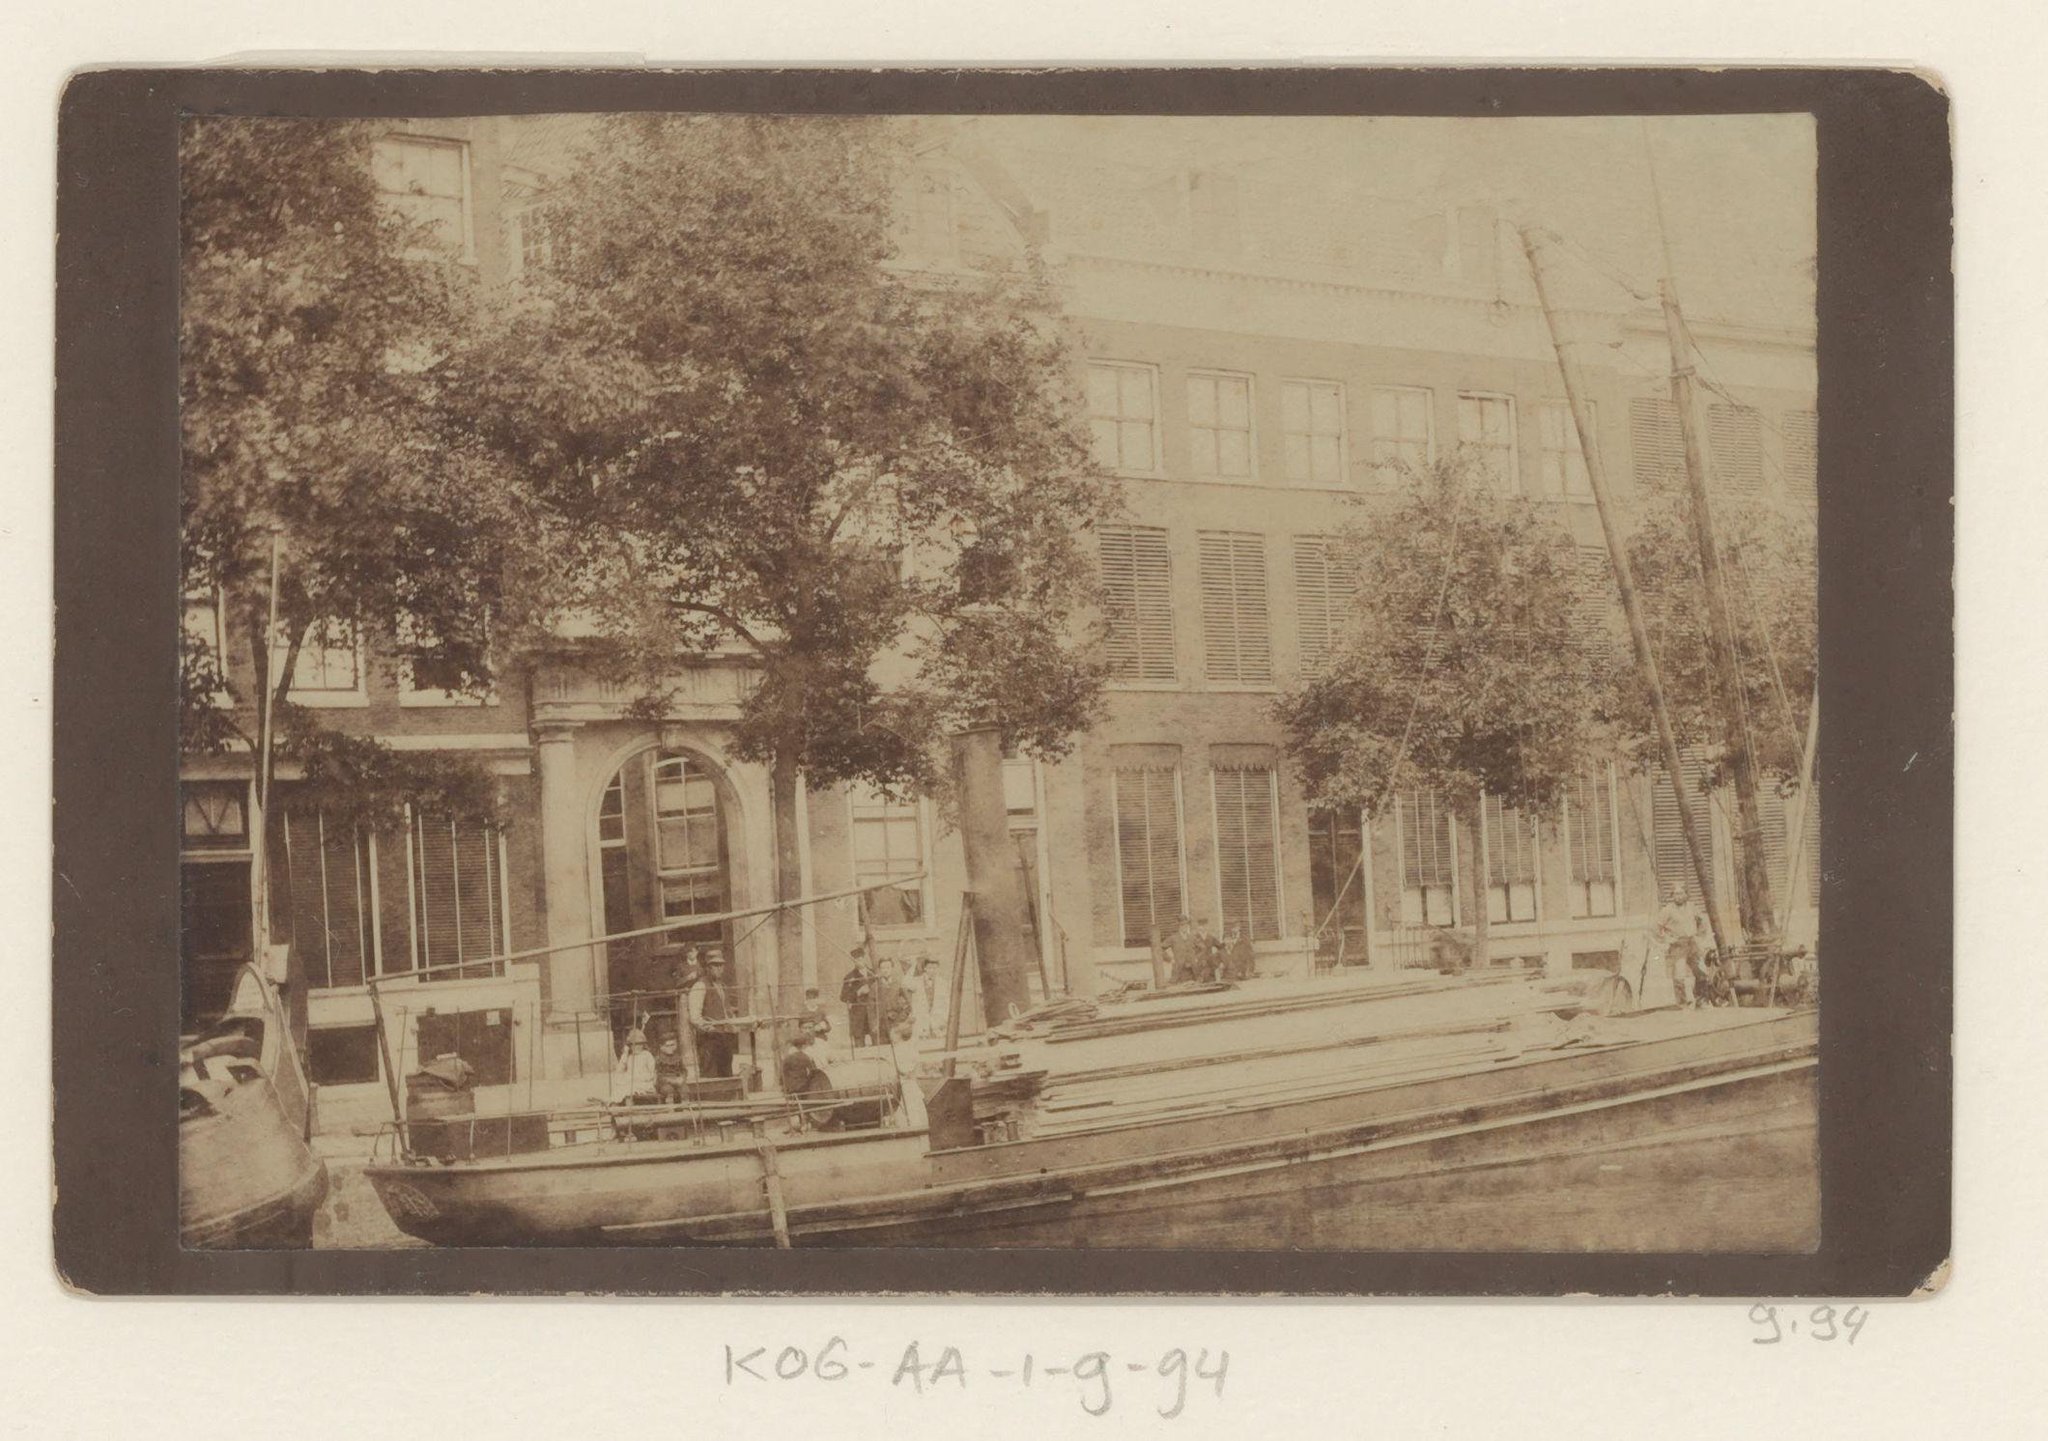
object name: cabinet photograph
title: Gezicht op de Kloveniersburgwal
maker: andreas theodorus rooswinkel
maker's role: fotograaf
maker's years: 1838-1909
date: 1868-1909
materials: cardboard, paper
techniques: albumen print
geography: amsterdam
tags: city-view in general; 'veduta', canal, the usual house or row of houses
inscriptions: collector's mark: ‘9.94’ Lugt 1641b, inscription: ‘Kloveniersburgwal’, stamp: ‘A.T. Rooswinkel / Photographe / Amsterdam.’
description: Onderwerpsrubriek binnen de Atlas Amsterdam: Kadijksplein, Karthuizerkerkhof, Kattegat, Kattenburg, Kapelsteeg O.Z., Enge Kerksteeg, Kerkstraat, Kinkerstraat, Kolk O.Z., Koningsplein, Kromboomsloot [Krom Boomssloot], Kostverlorenkade, Kwakersdwarspad, Kalverstraat, Keizersgracht (v.d. Brouwersgracht – Amstel), Klerensloot (Gedempte), Klimopstraat, Kloveniersburgwal, Kraansluis.